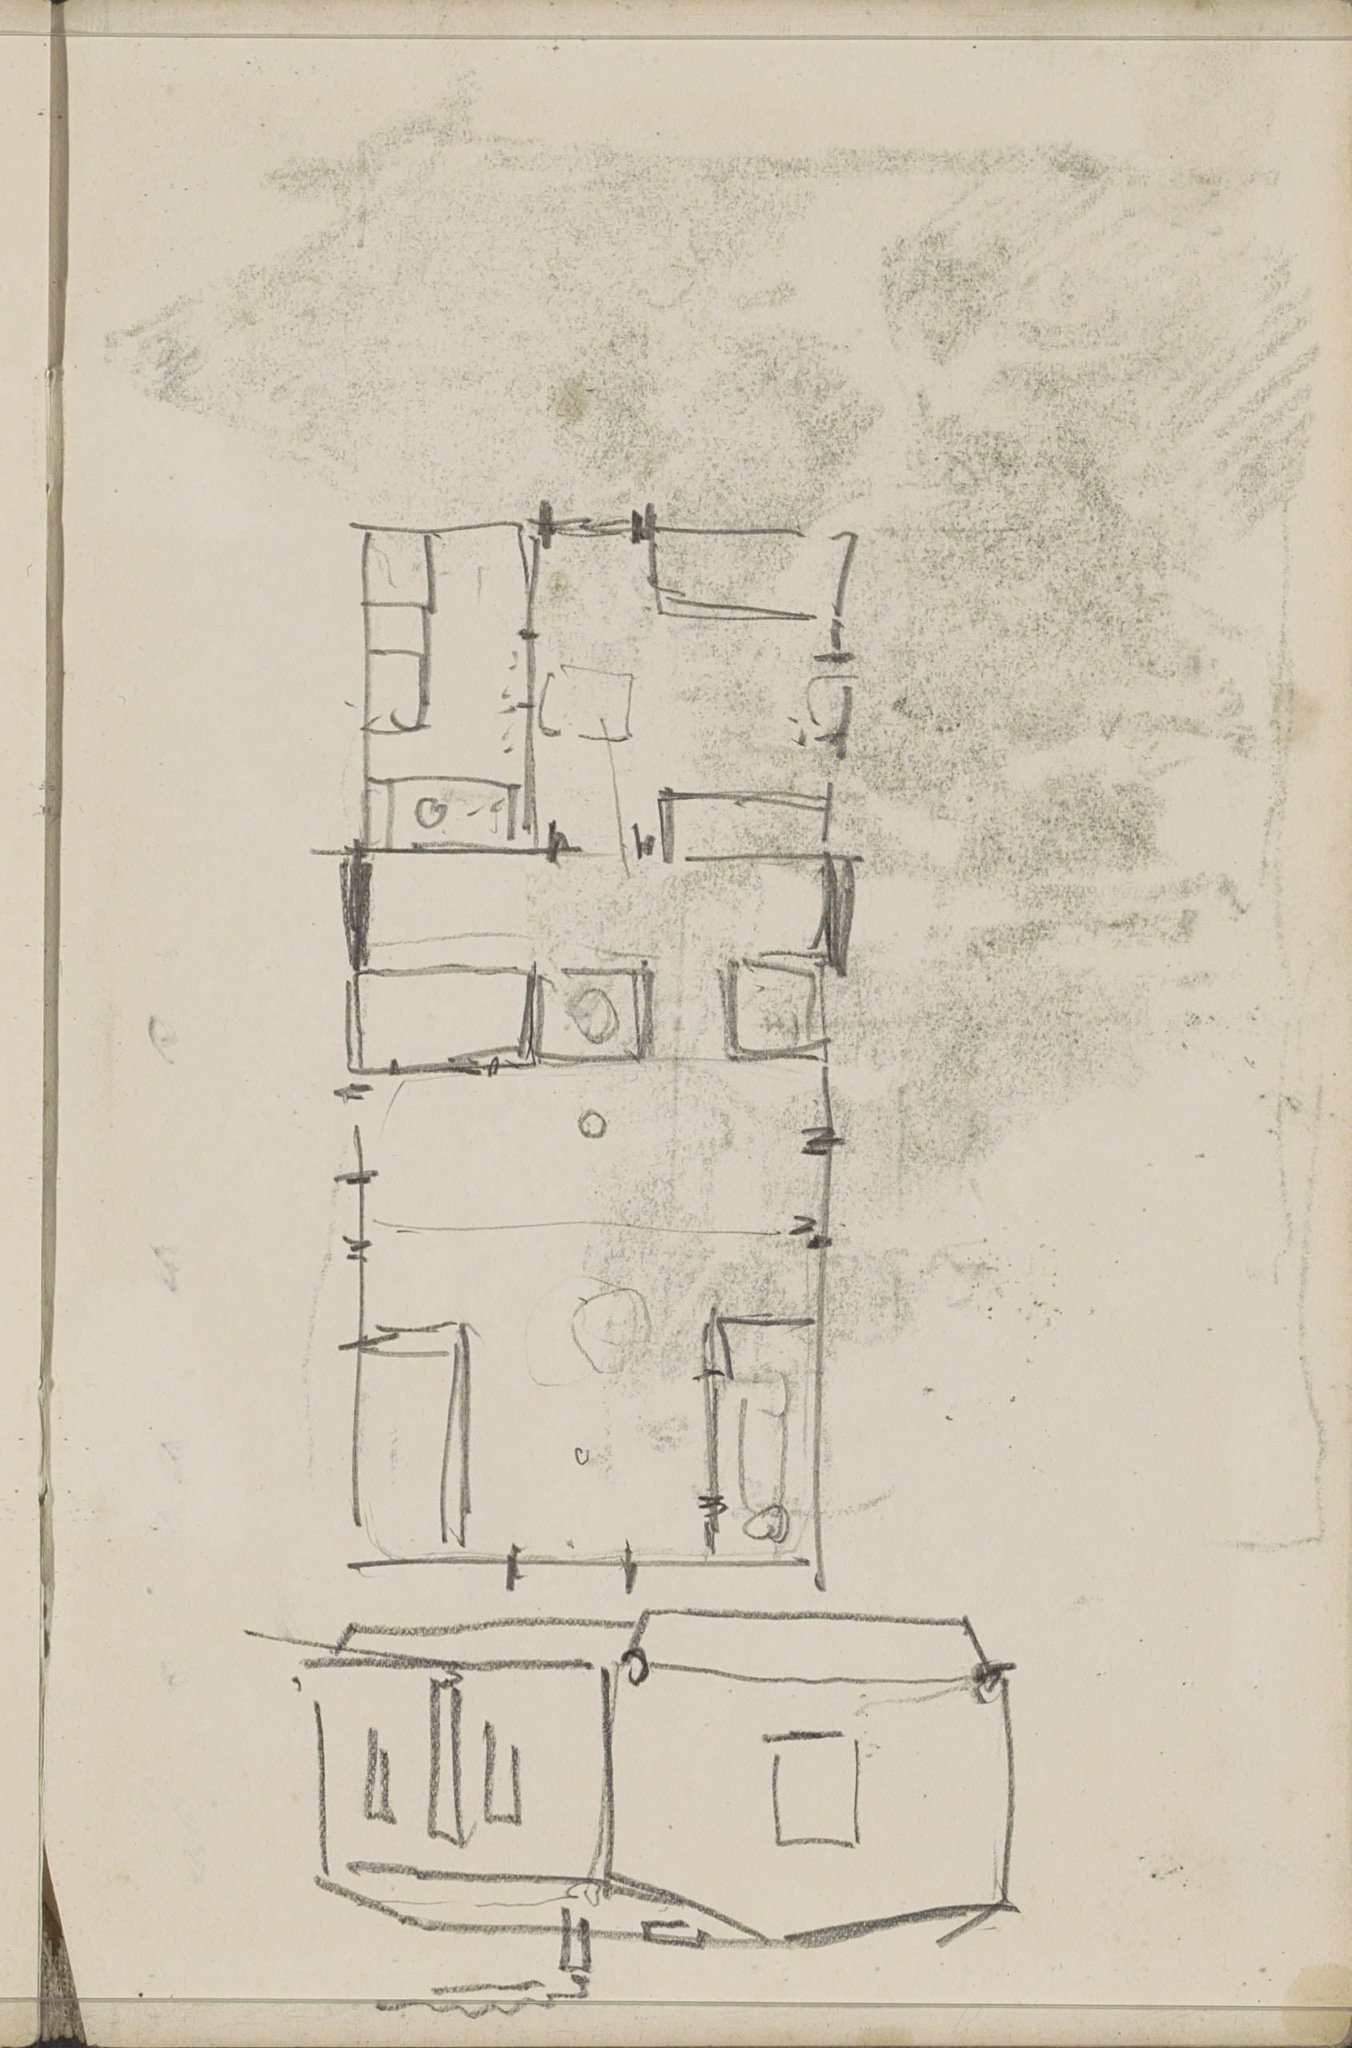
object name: sketchbook leaf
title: Zijaanzicht en een plattegrond van een huis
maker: cornelis vreedenburgh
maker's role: draughtsman, print maker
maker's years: 1880-1946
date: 1890-1946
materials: chalk, paper, pencil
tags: façade (of house or building), plan ~ architecture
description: Blad 47 recto uit een schetsboek met 47 bladen.